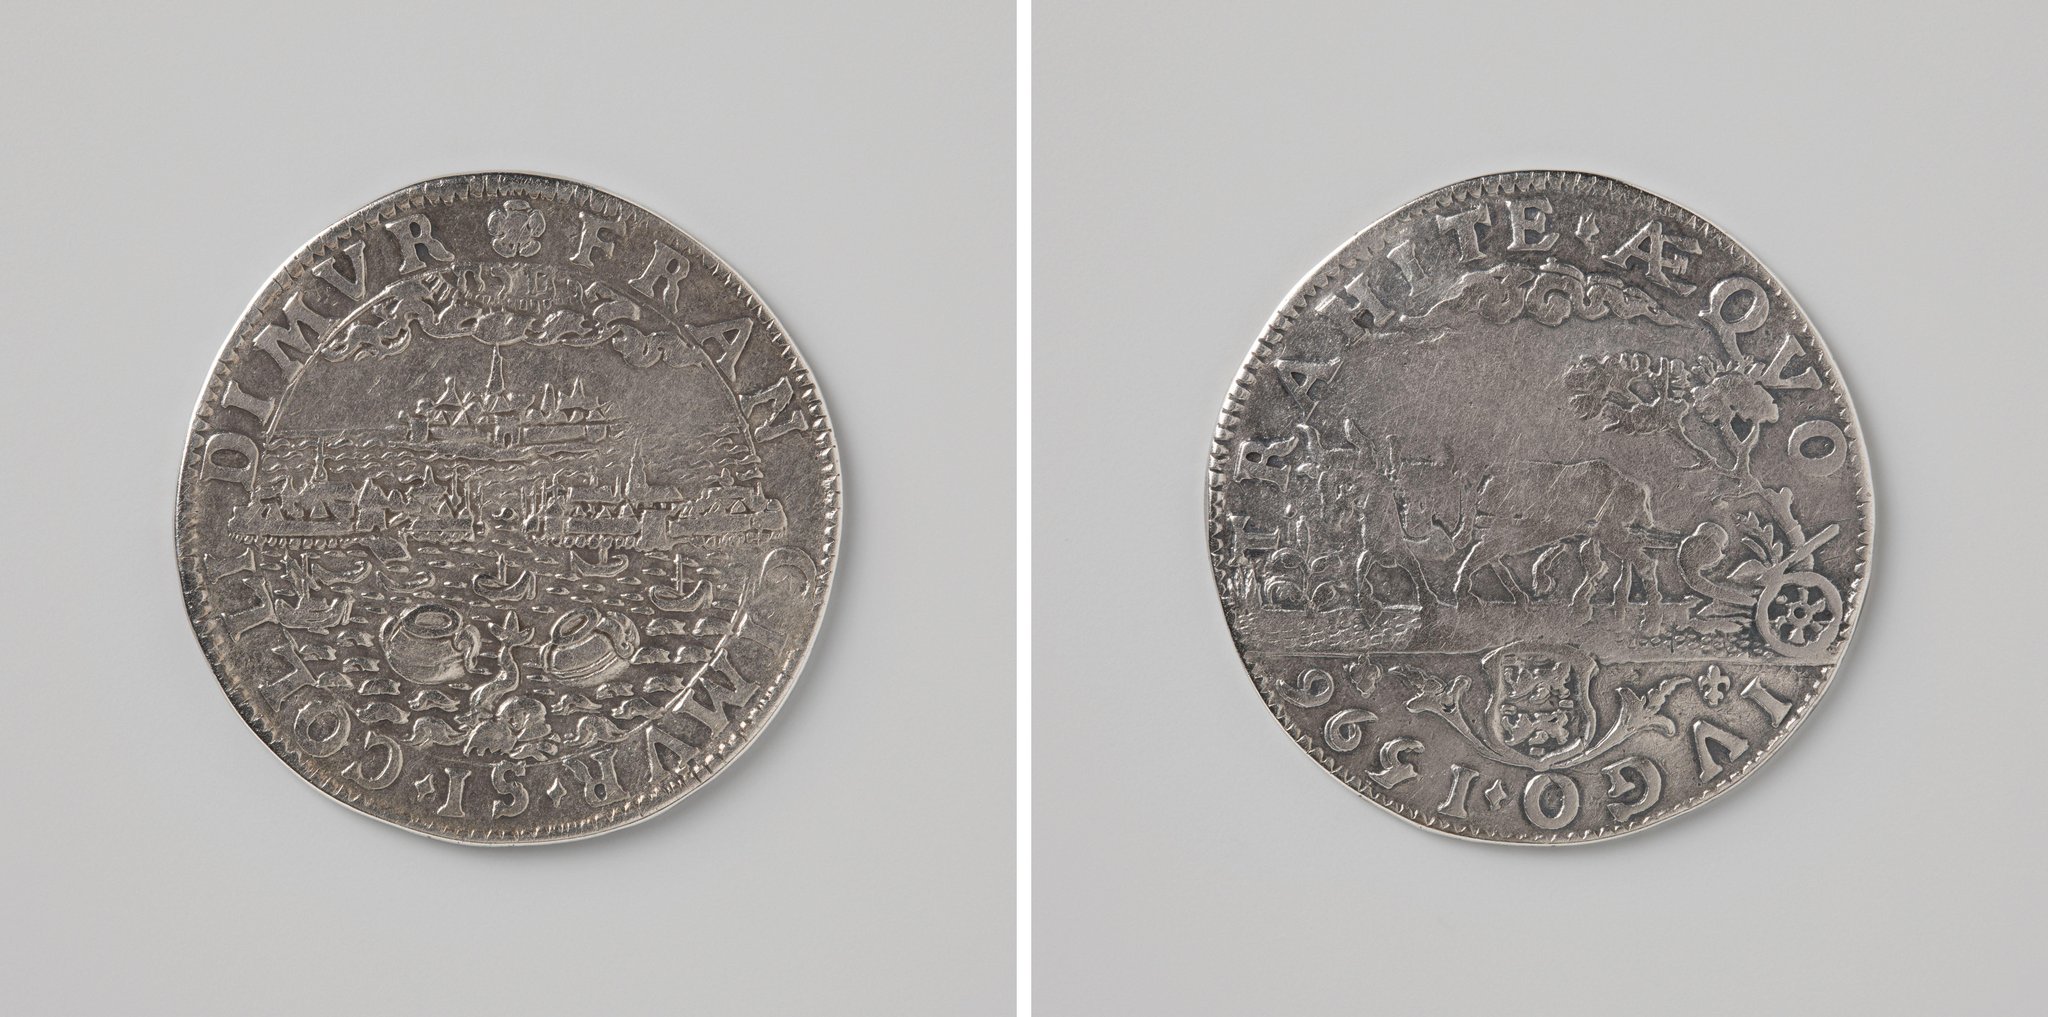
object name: history medal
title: Aansporing tot eenheid in West-Friesland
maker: paulus van wtewael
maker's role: die cutter, draughtsman, print maker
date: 1596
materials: silver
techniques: striking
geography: west frisia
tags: enkhuizen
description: Zilveren penning. Voorzijde: drie steden aan water; op voorgrond bootjes, twee potten en vis binnen omschrift. Keerzijde: span ossen voor ploeg binnen omschrift.